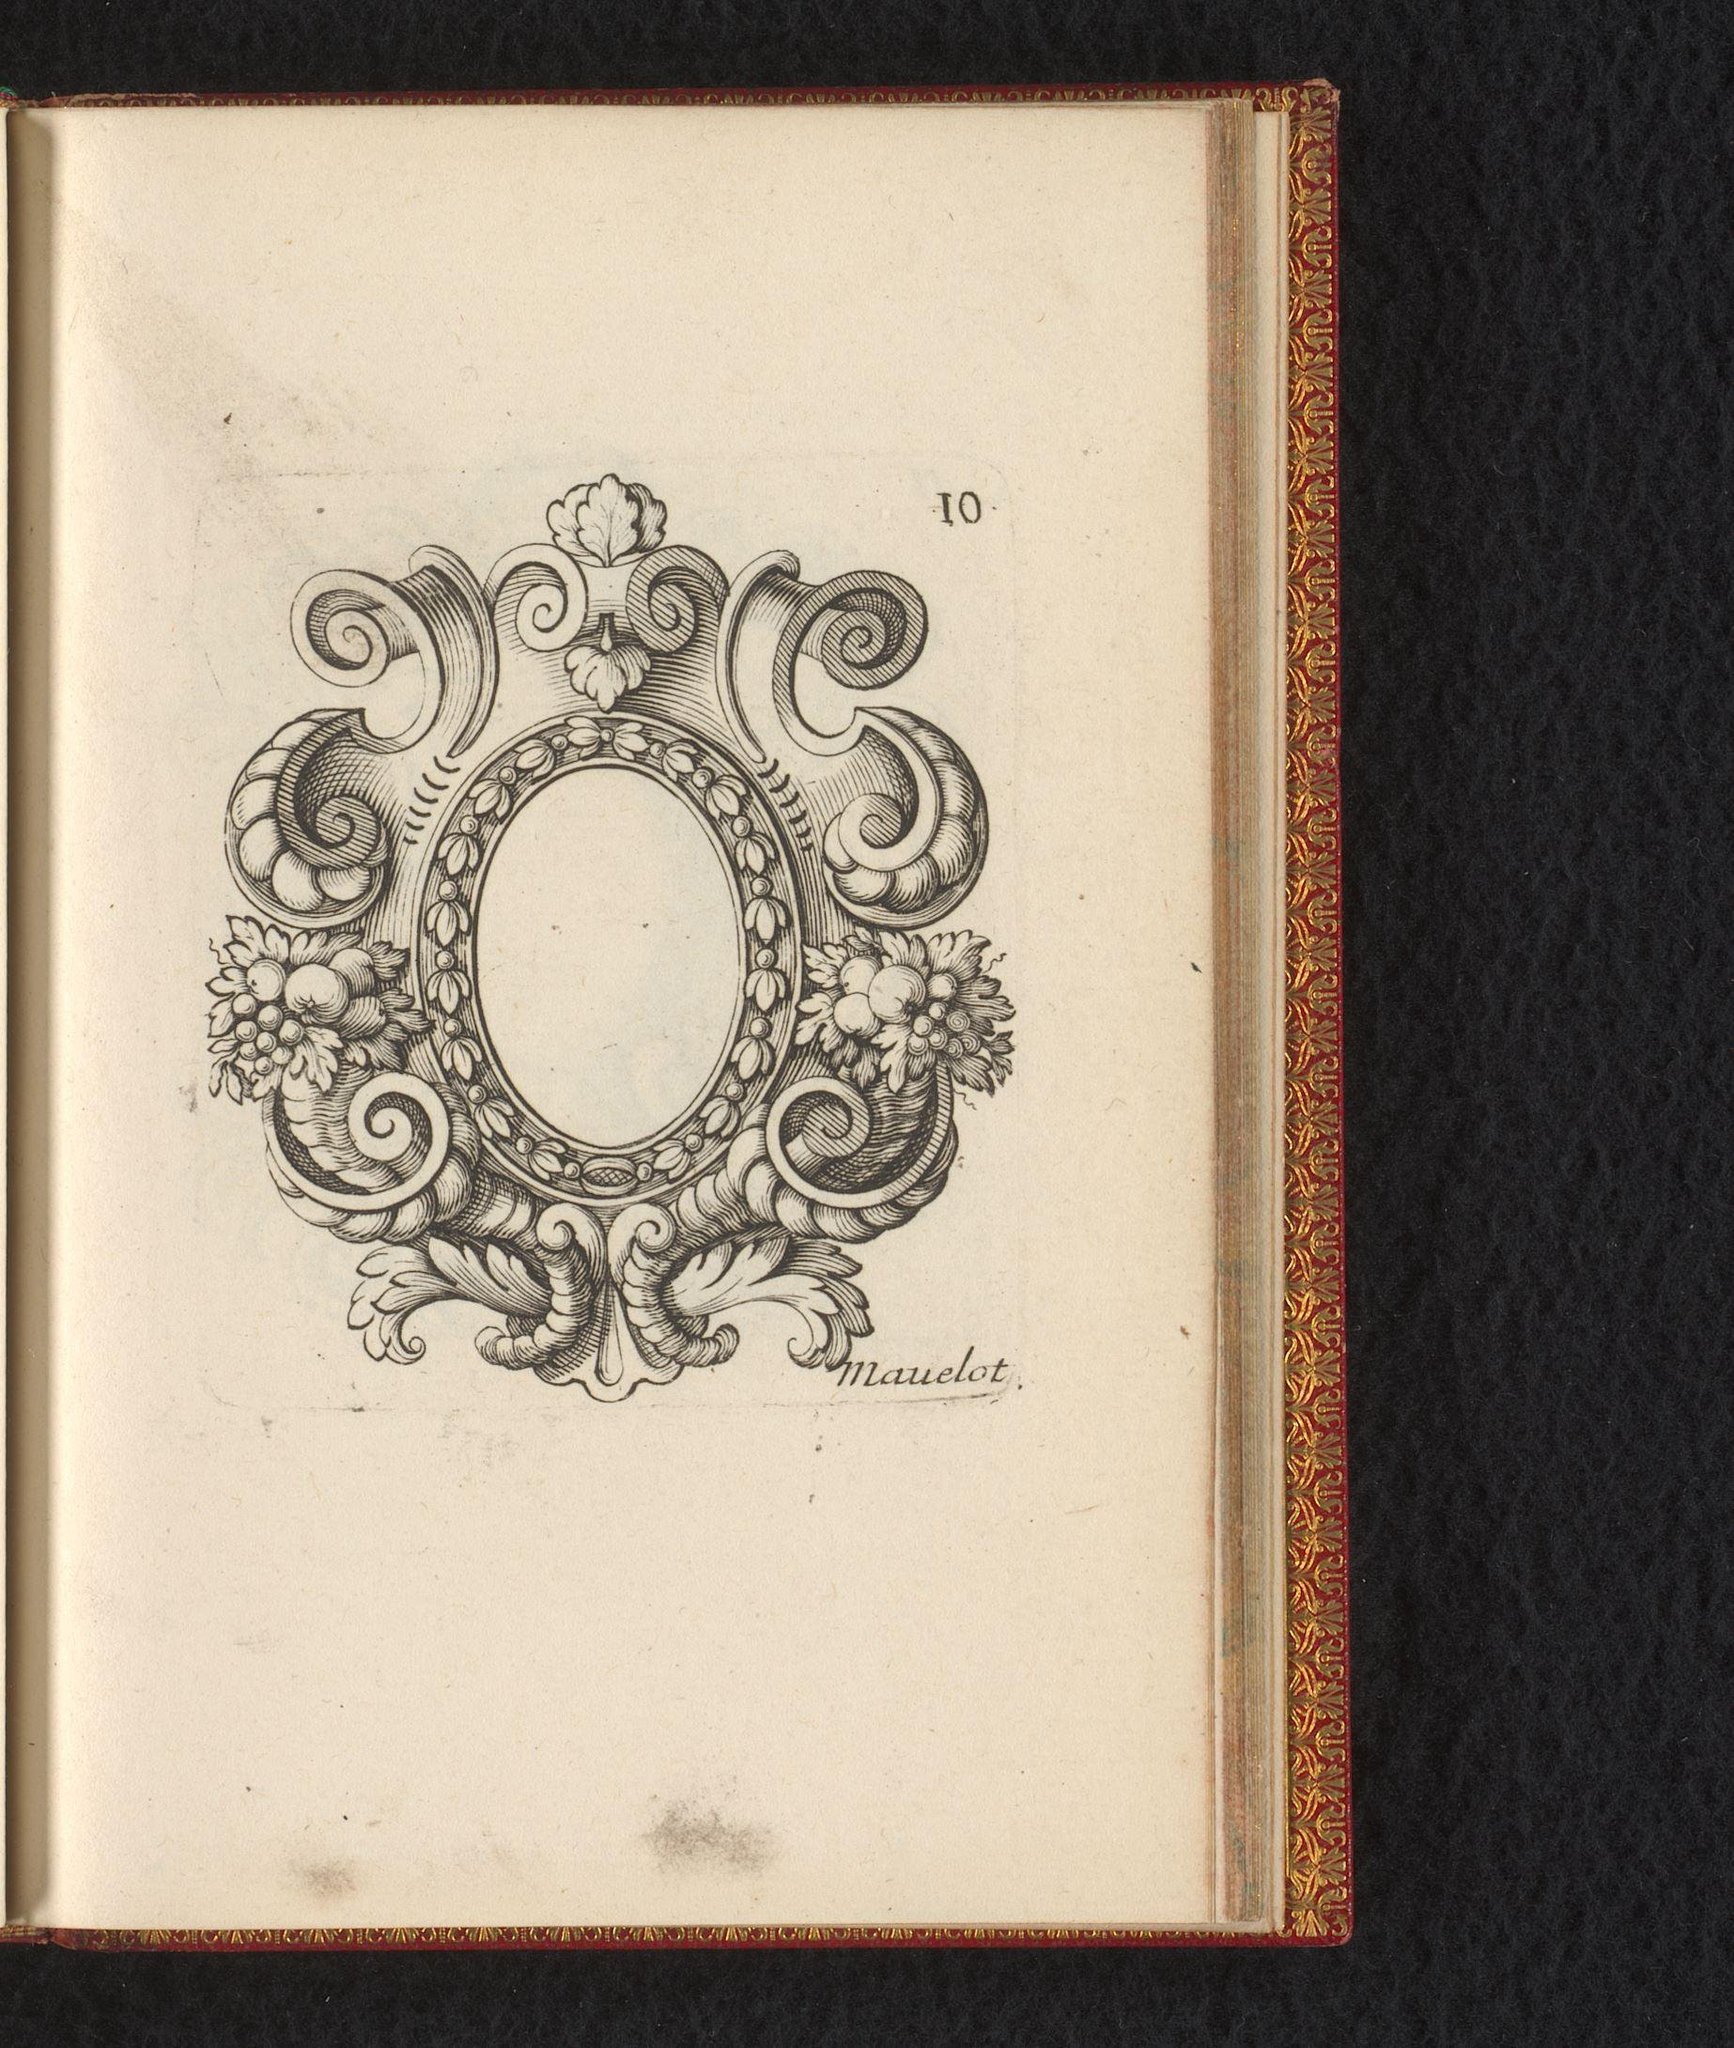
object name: album leaf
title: Cartouche met twee hoornen des overvloeds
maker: charles mavelot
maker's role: draughtsman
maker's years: 1680-1742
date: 1685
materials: paper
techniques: engraving, etching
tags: 'cornucopia', horn of plenty, scrollwork, strapwork ~ ornament, ornament ~ cartouche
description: Rechtsboven genummerd: 10. Prent maakt deel uit van een album.